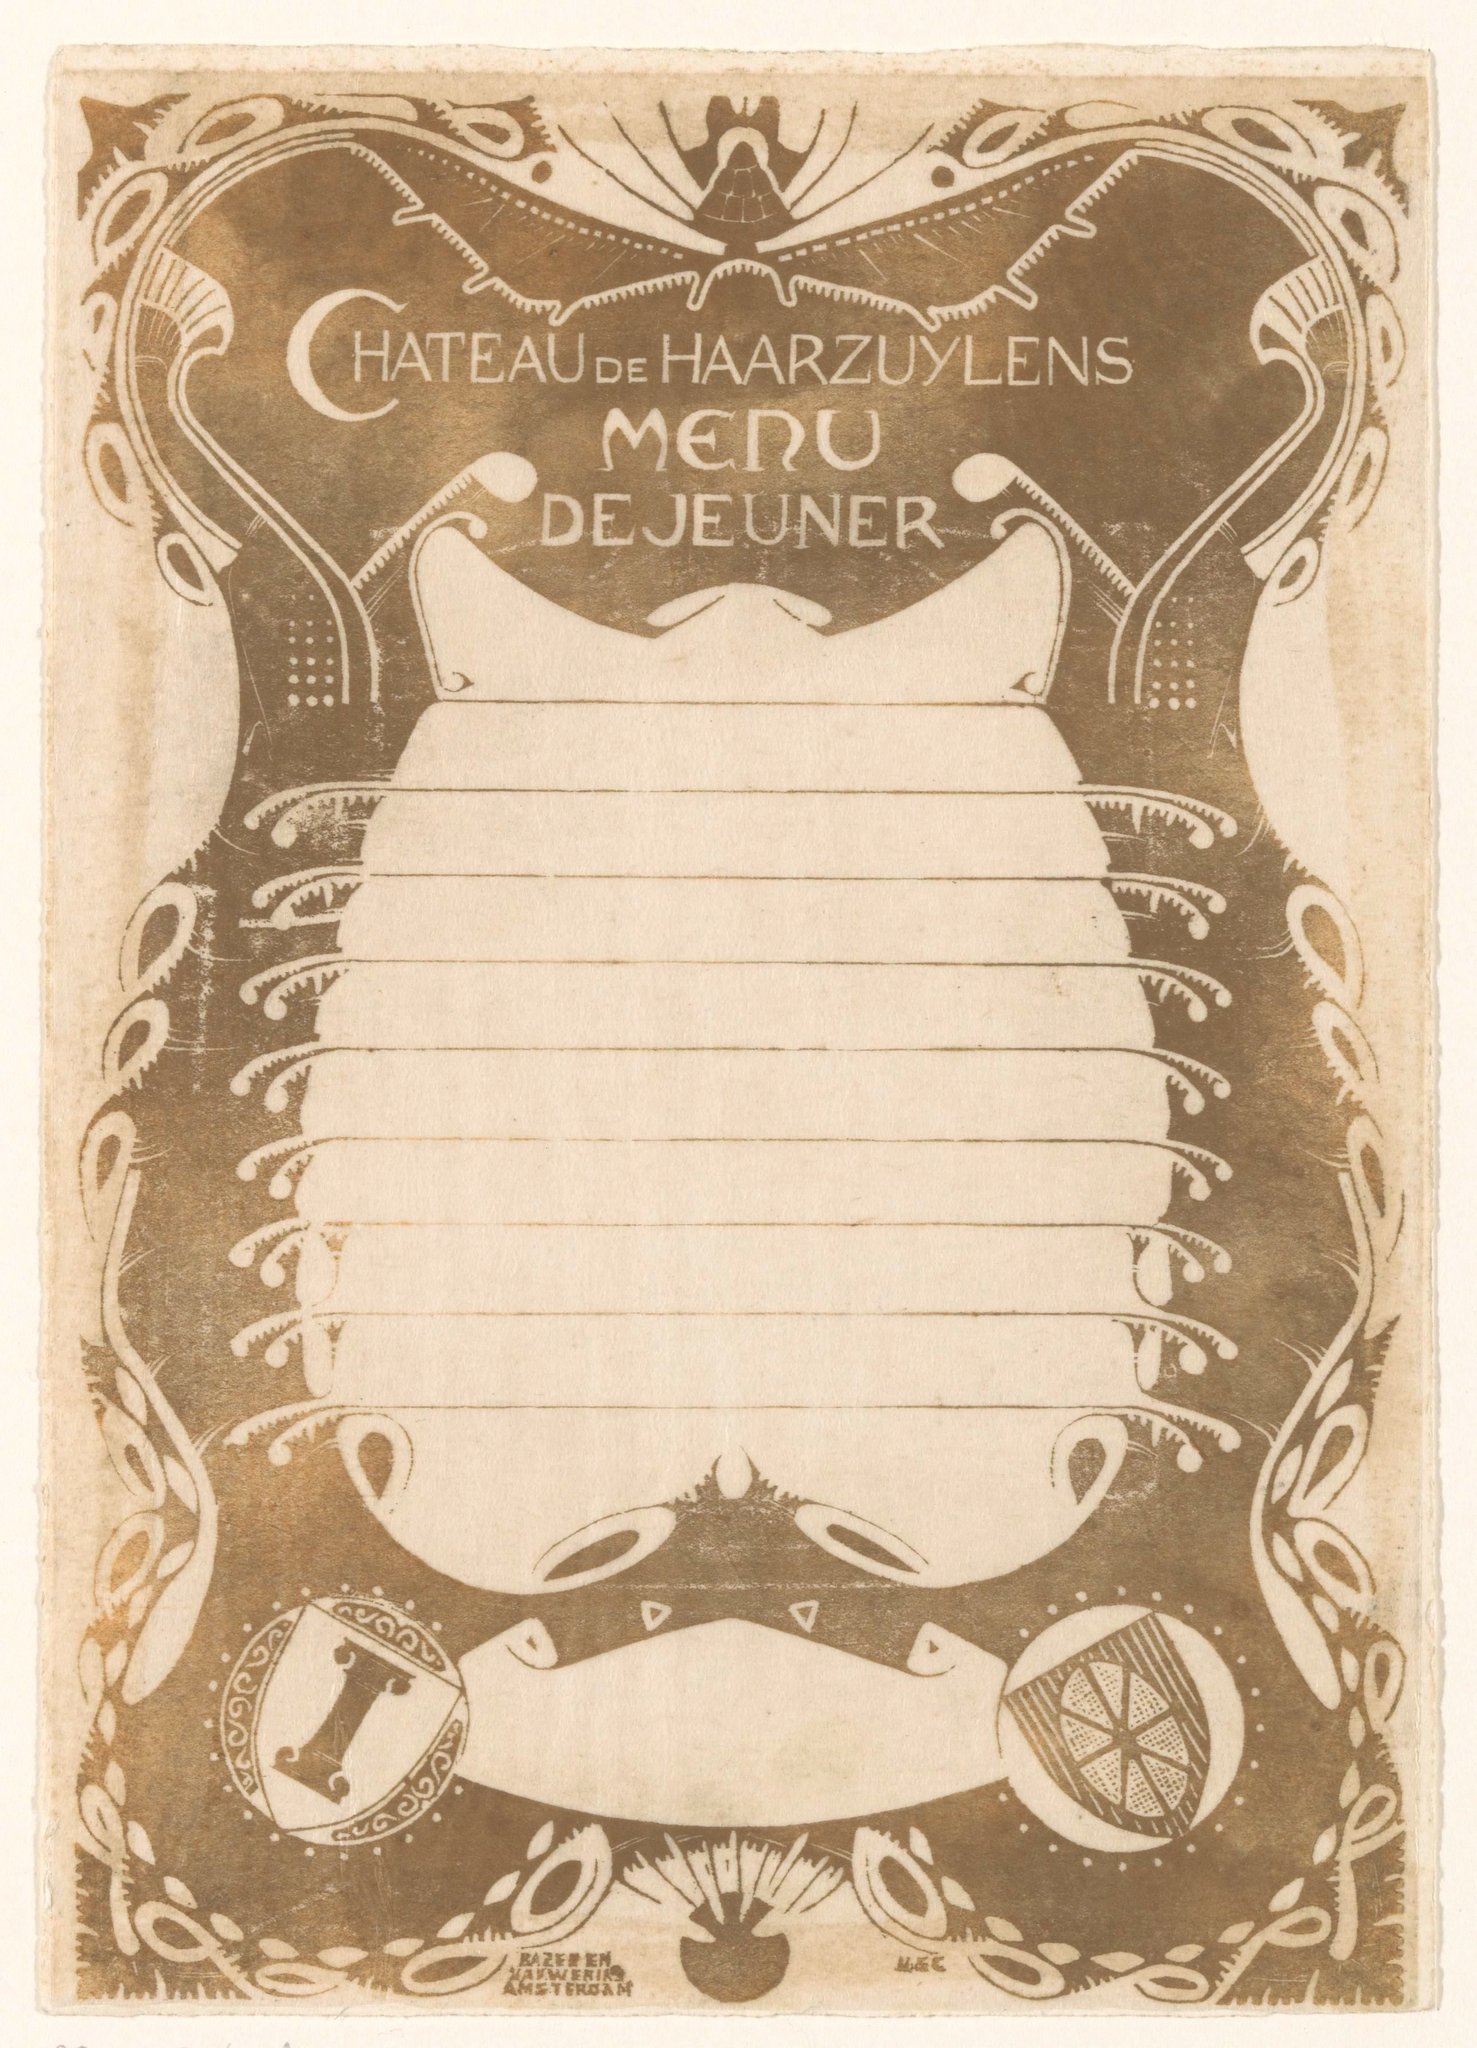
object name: menu, menukaart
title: Menukaart Château de Haarzuijlens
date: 1896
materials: paper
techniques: woodcut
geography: amsterdam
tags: kasteel de haar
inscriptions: collector's mark: Lugt 2228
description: Menukaart voor Kasteel de Haar bij Haarzuilens.